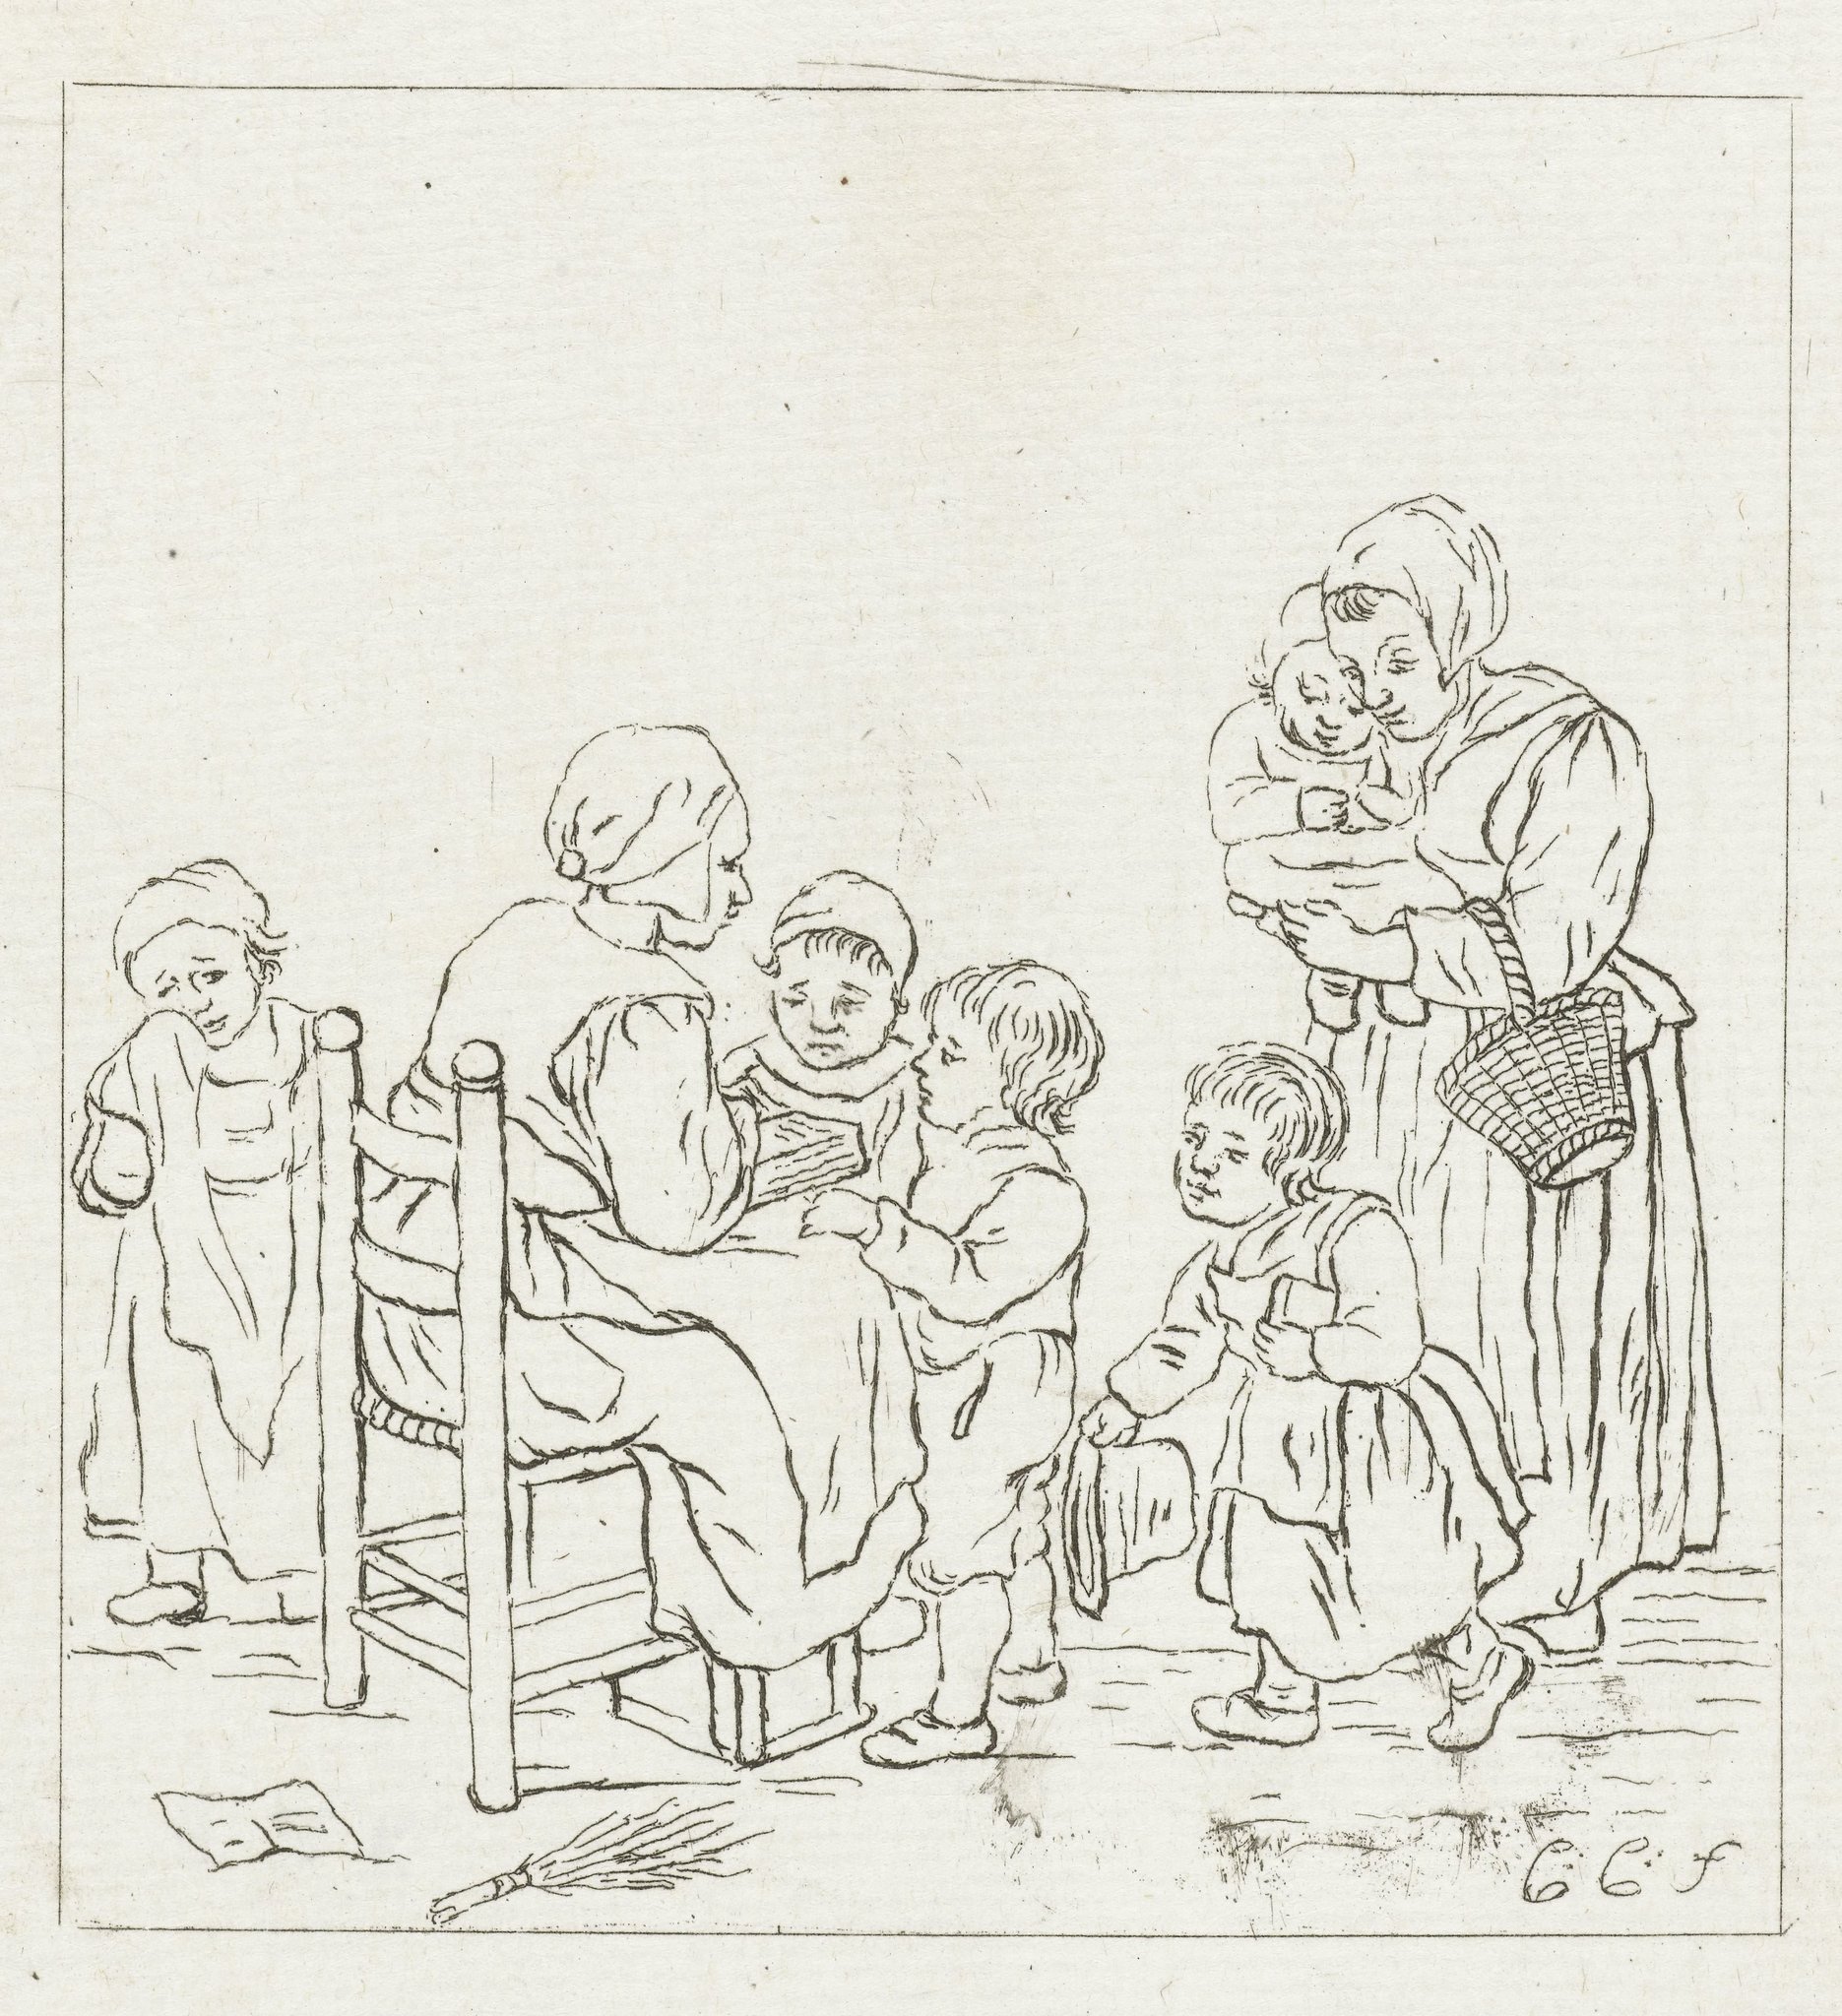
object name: print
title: Schoolklas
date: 1779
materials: paper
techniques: etching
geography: leiden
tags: teacher and pupil, rod, birch ~ punishment at school, nursery school, mischievous child (at school)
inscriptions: collector's mark: Lugt 2233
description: Een kinderschool. Een lerares zit op een stoel en leest kinderen de les uit een boek. Rechts komt een moeder haar dochter brengen. Links staat een meisje te huilen. Onder de stoel van de lerares ligt een roede.